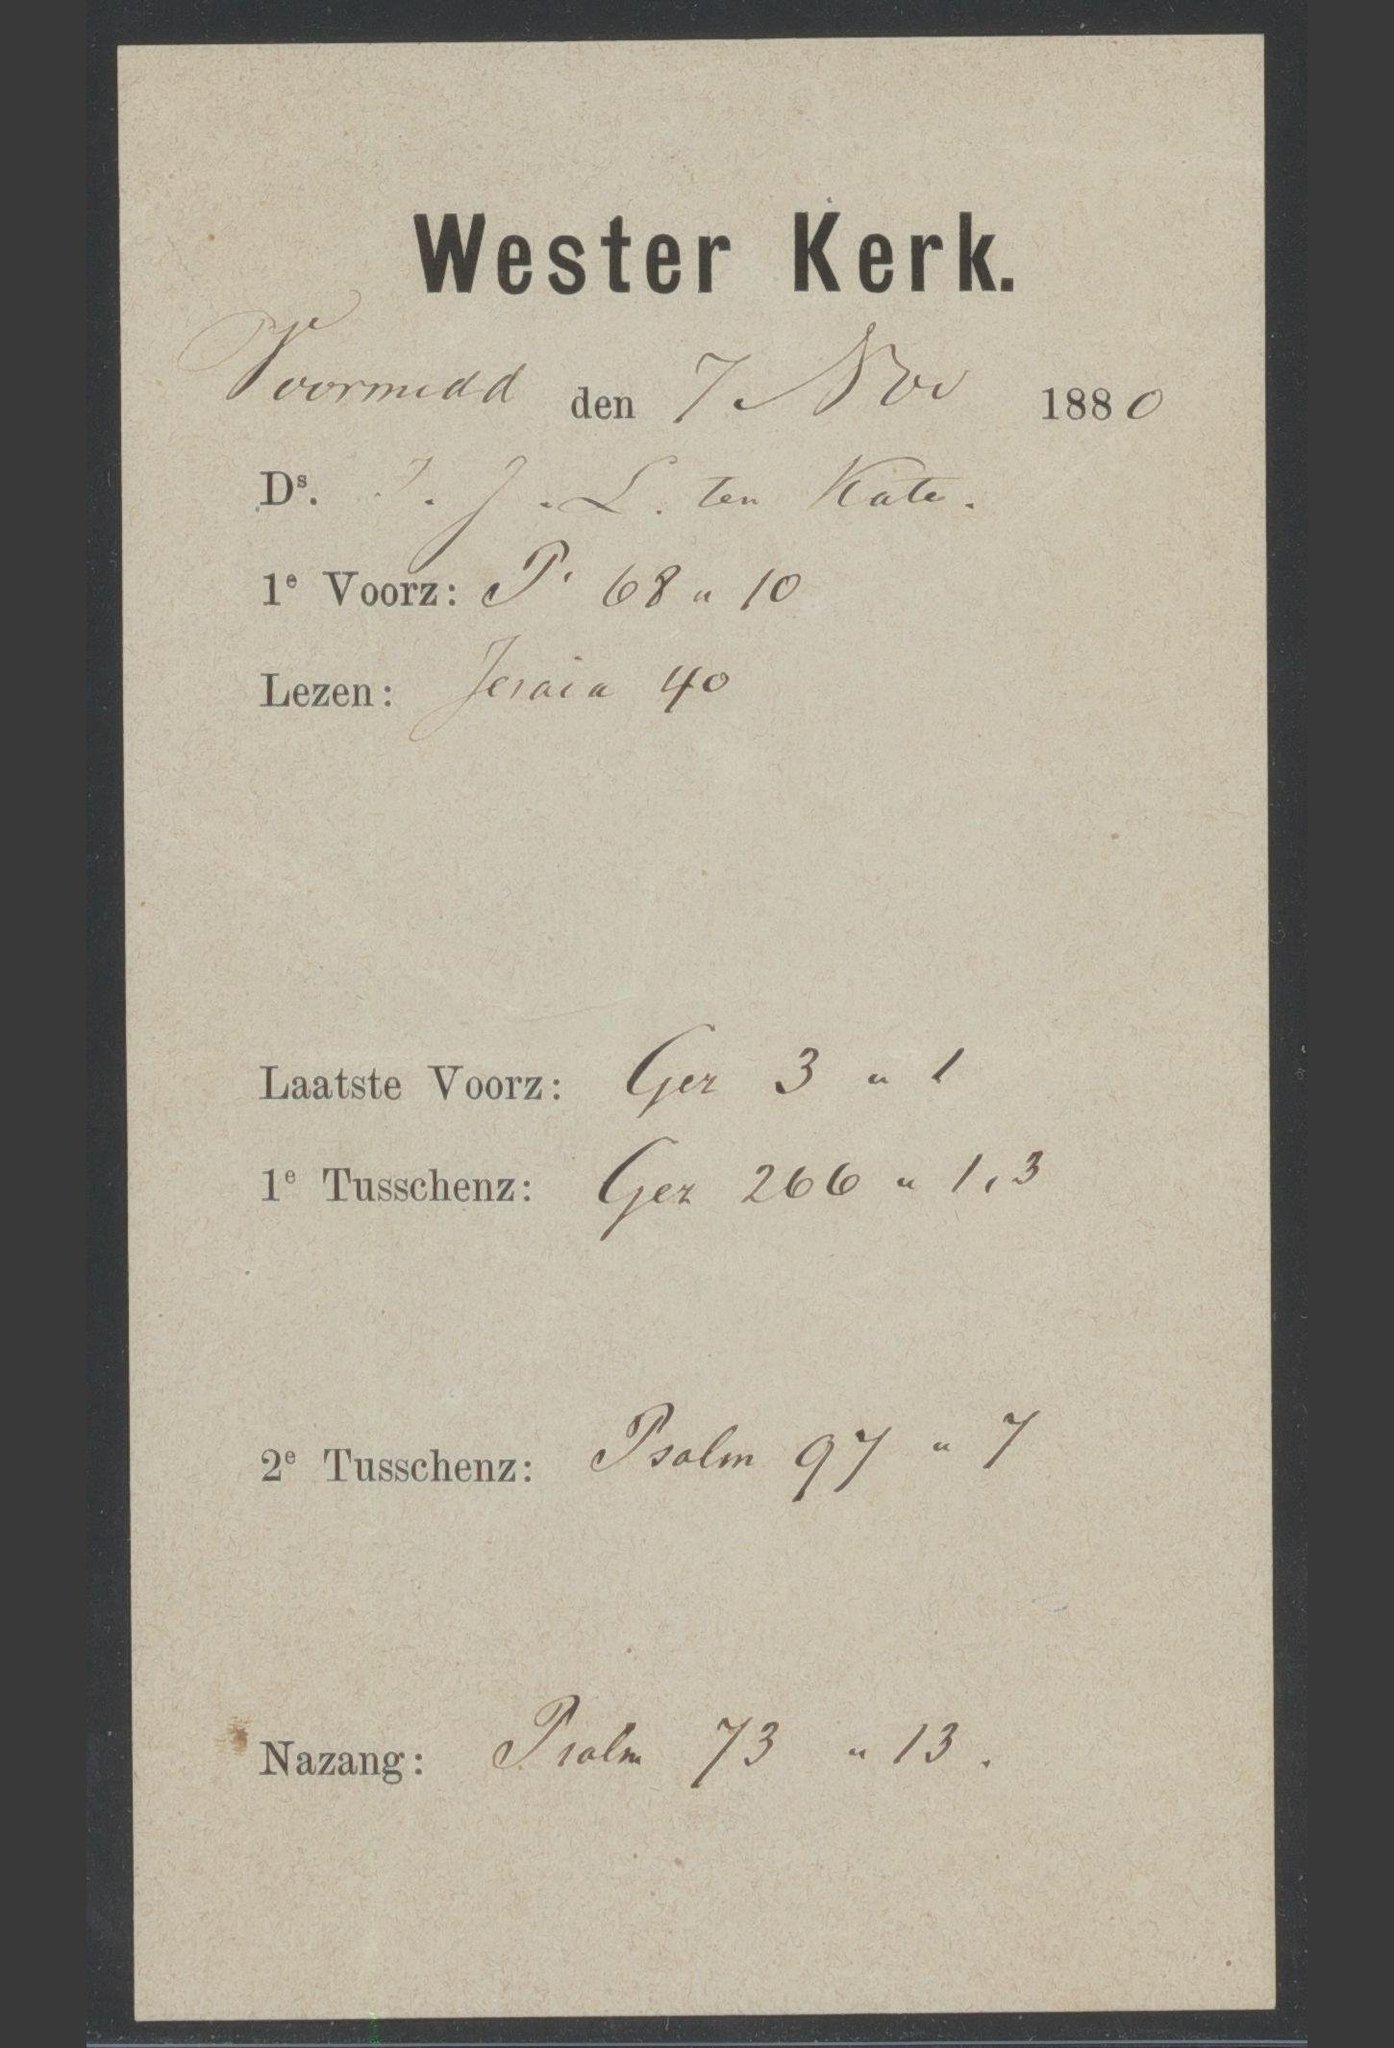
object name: text sheet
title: Programma van de mis op in de voormiddag van 7 november 1880 in de Westerkerk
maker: Anonymous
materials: paper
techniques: letterpress printing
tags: westerkerk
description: Programma van de mis op in de voormiddag van 7 november 1880 in de Westerkerk. Het blad is voorgedrukt en de datum, Bijbelverzen en psalmen zijn met de hand genoteerd. Onderwerpsrubrieken binnen de Atlas Zeden en Gewoonten: Godsdienst, Ned. Hervormden, (Oudtijds Gereformeerden).